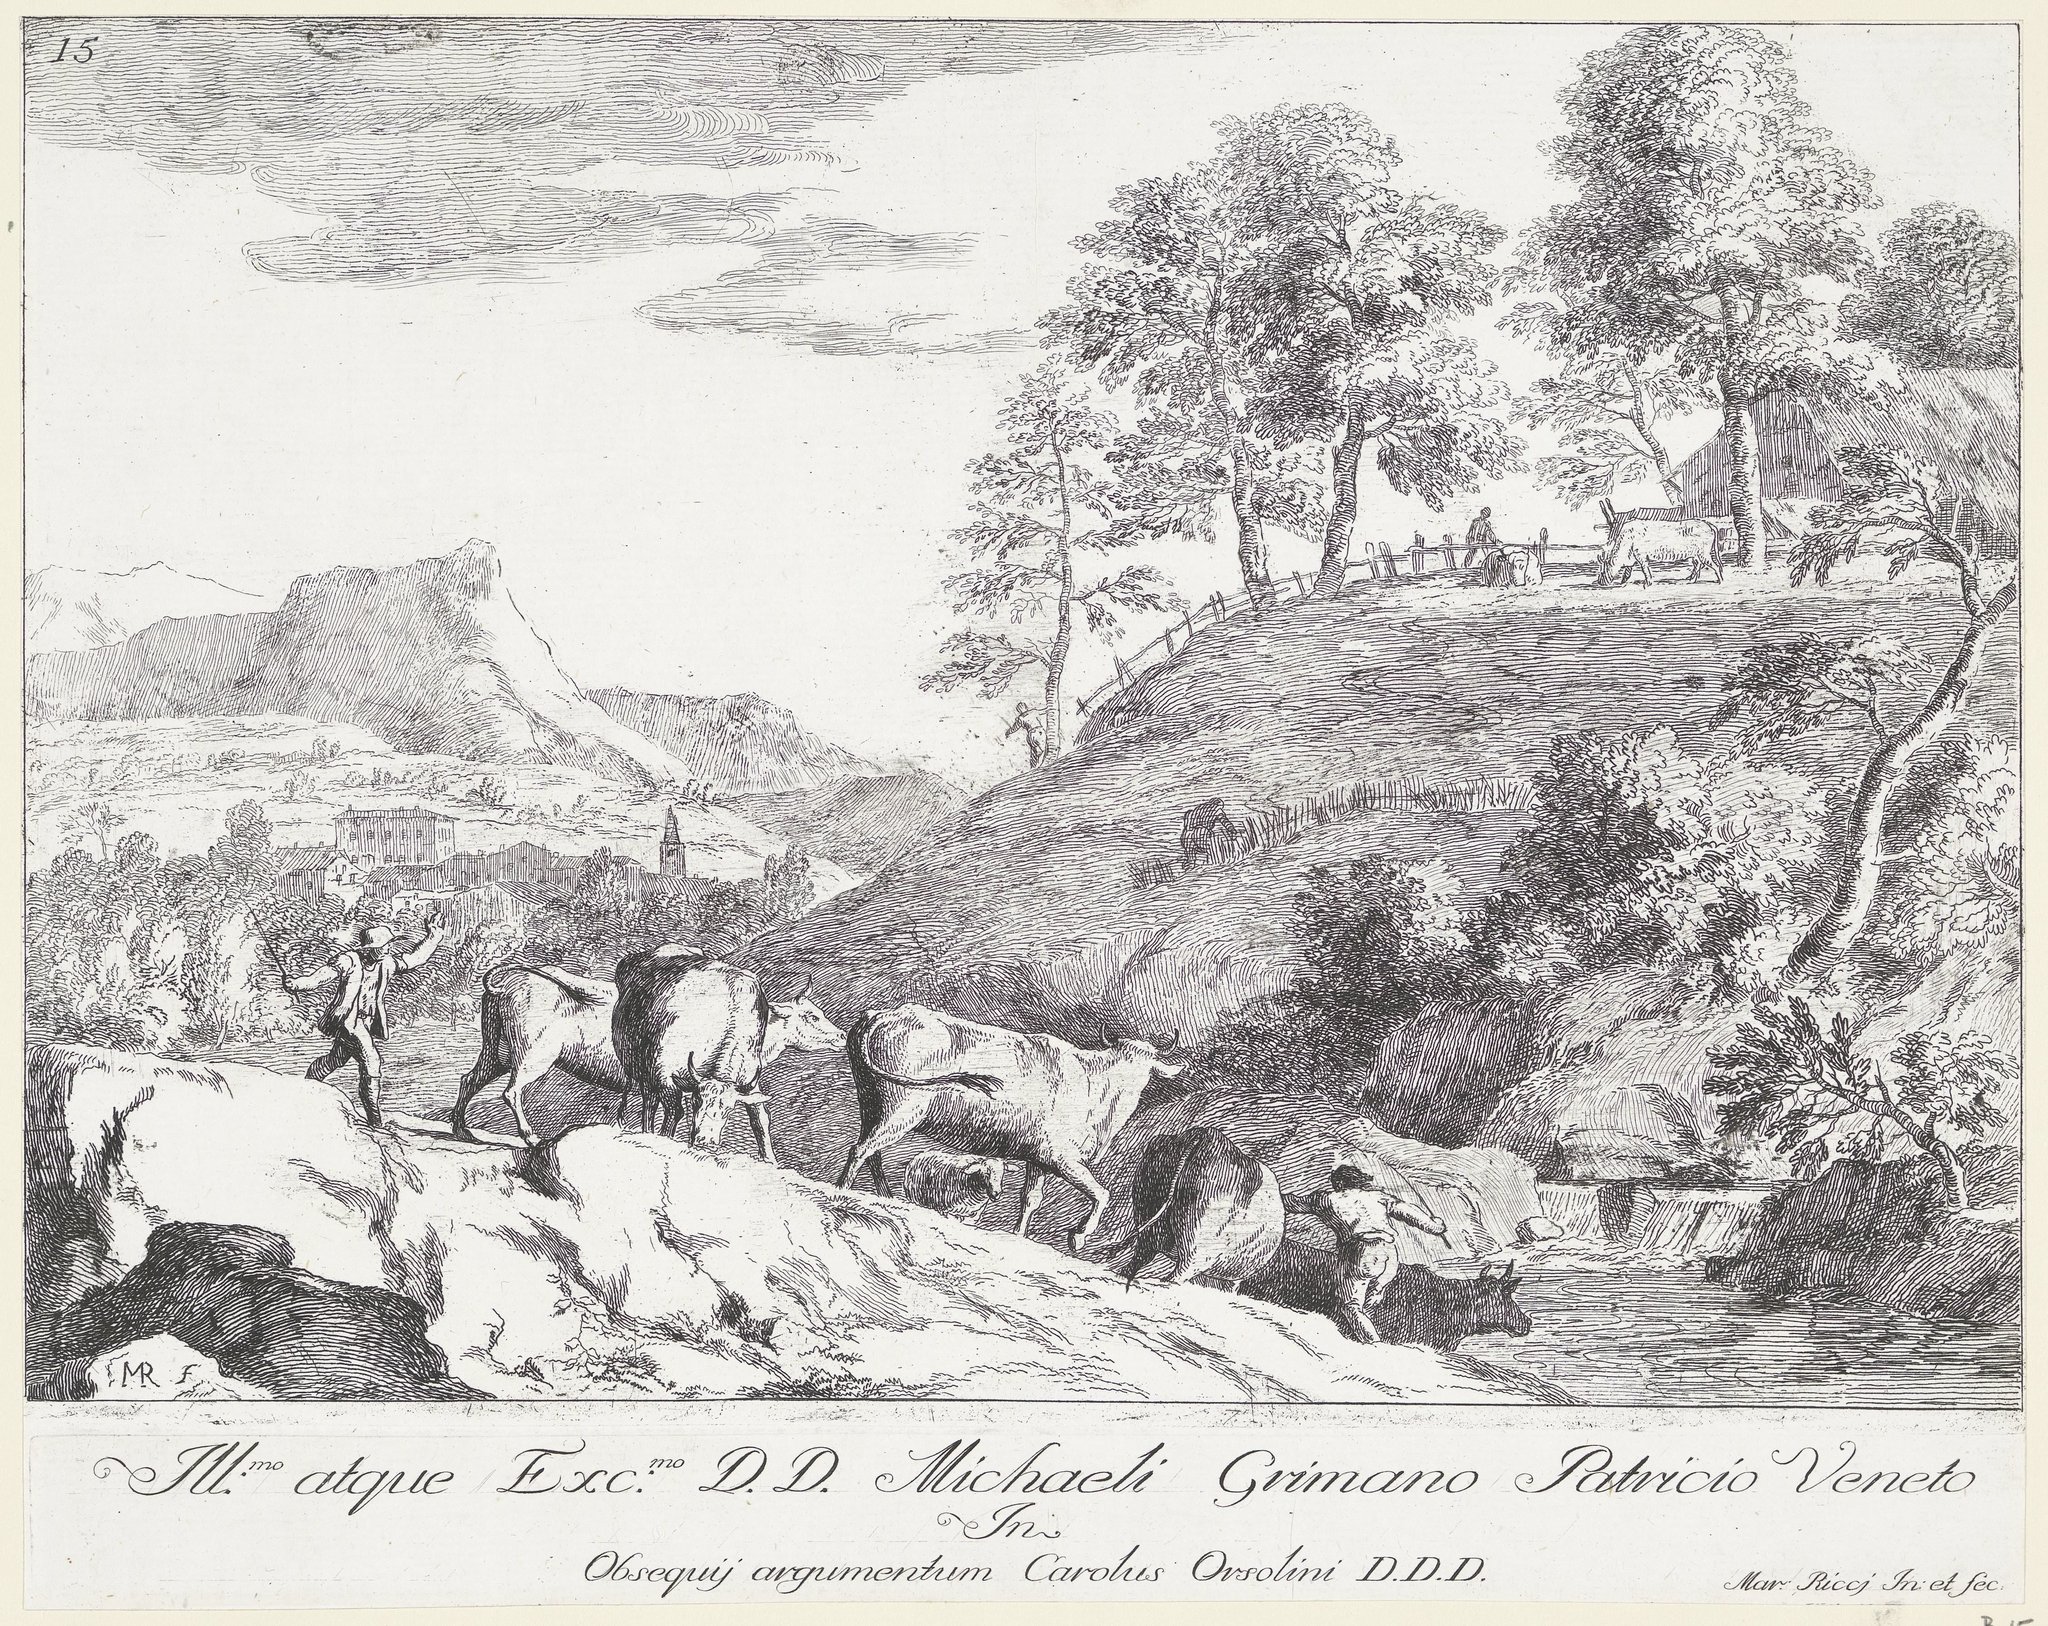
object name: print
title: Varia Marci Ricci Pictoris prestantissimi Experiment (...)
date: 1730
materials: paper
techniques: etching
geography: italy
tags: landscapes, river, herding, herdsman, herdswoman, shepherd, shepherdess, cowherd, etc., herd, flock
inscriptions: collector's mark: Lugt 2228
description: Deze prent maakt deel uit van een reeks van twintig prenten door Marco Ricci. De prenten zijn na de dood van Ricci in 1730 gebundeld door Carlo Orsolini en voorzien van een titelprent.